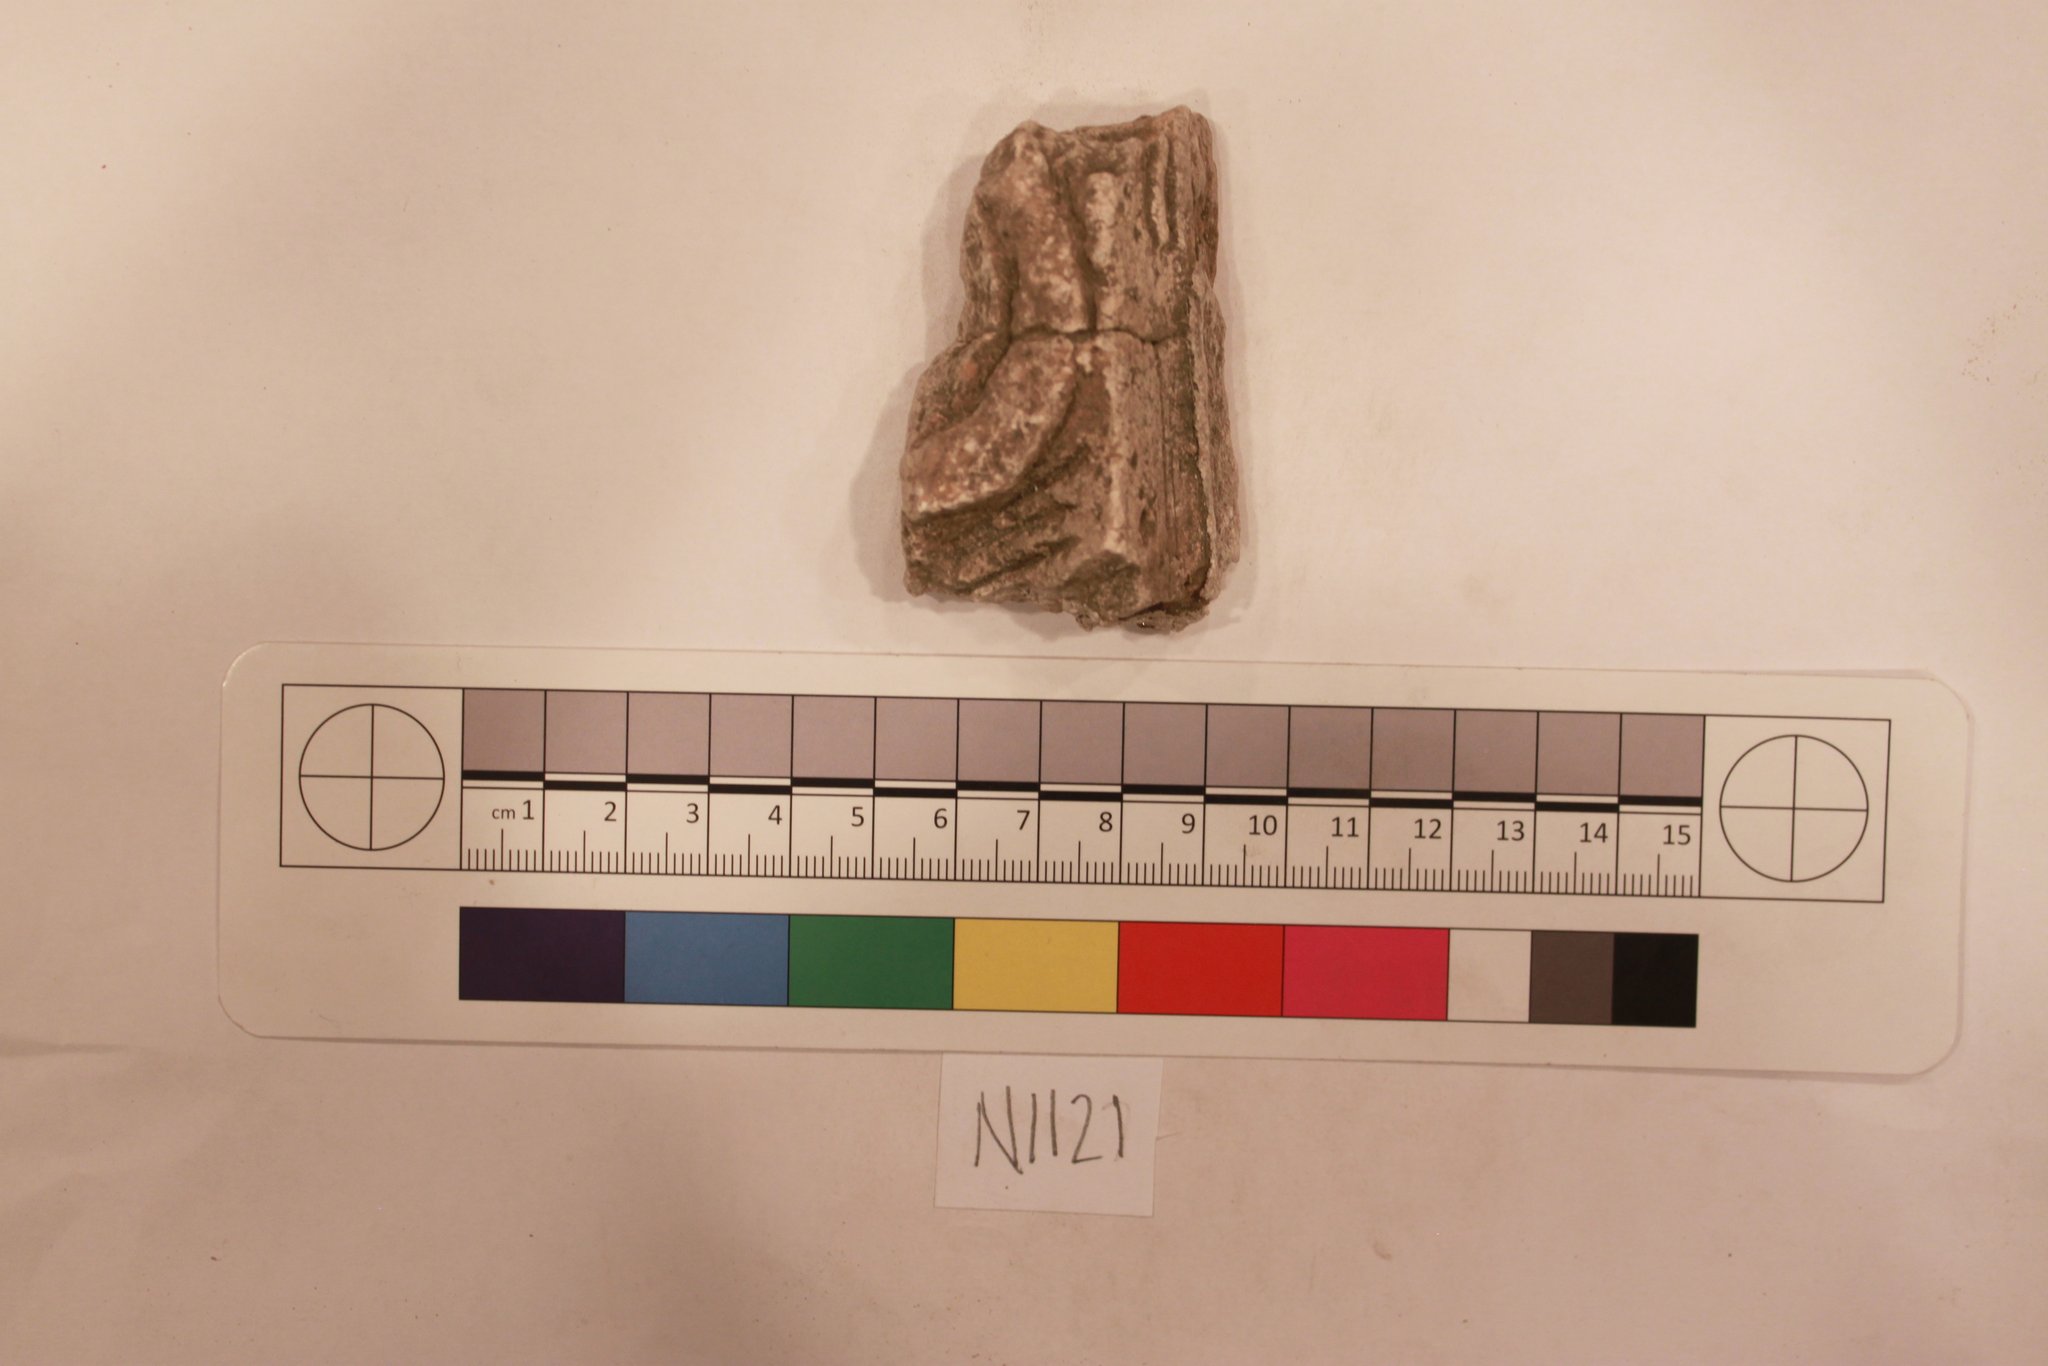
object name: fragment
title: Stucco Fragment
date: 701-1200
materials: plaster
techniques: carving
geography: iran